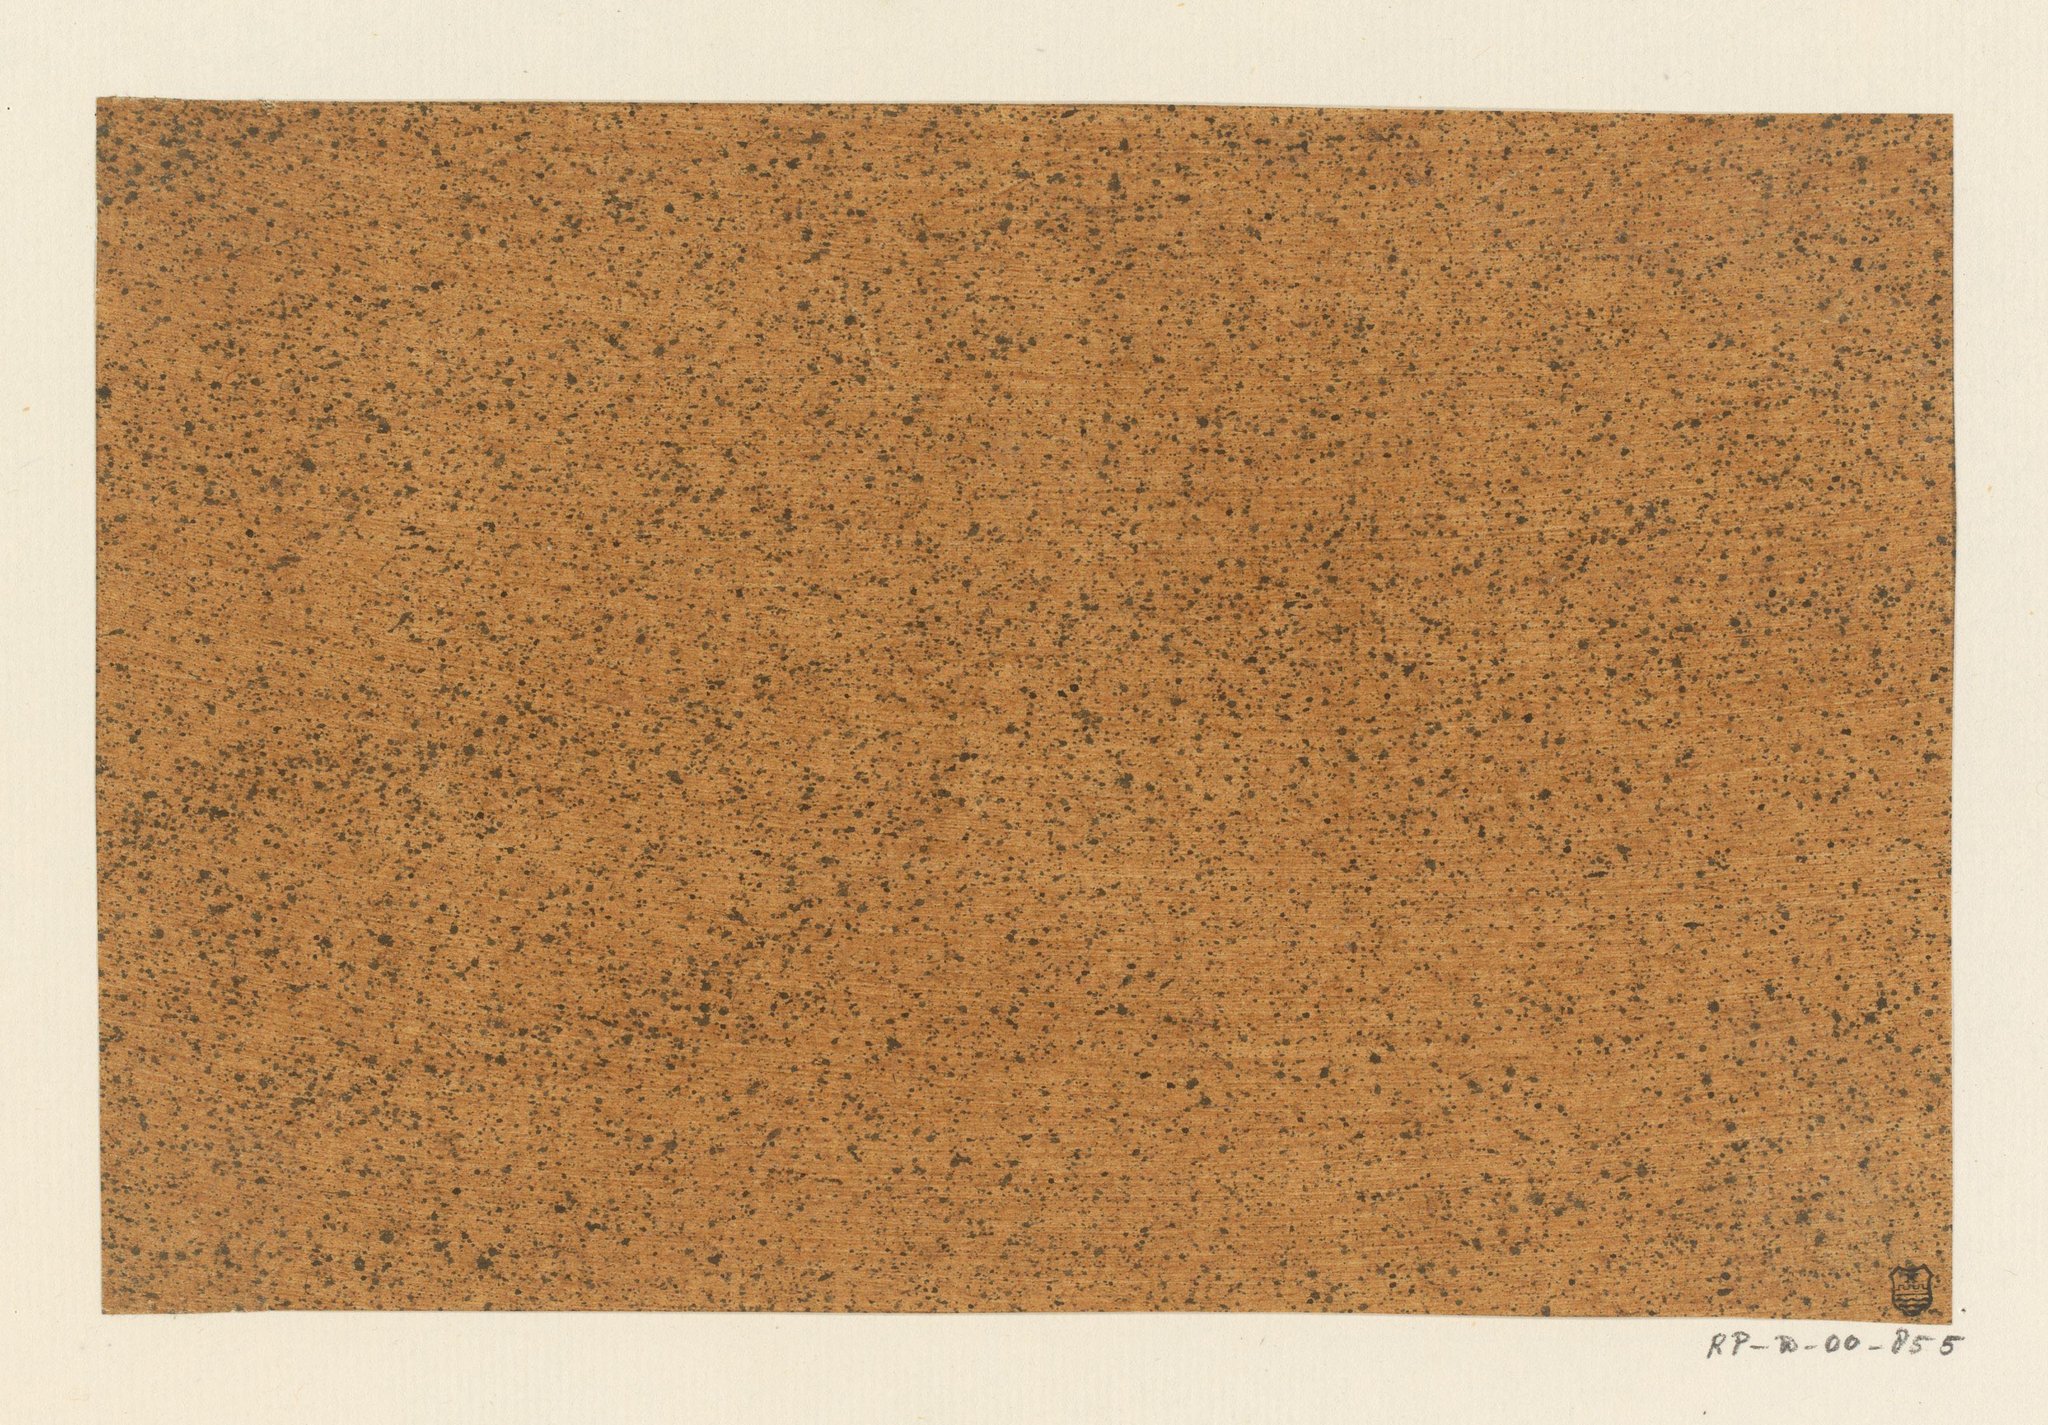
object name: sprinkled paper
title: Zwart gespikkeld geelbruin papier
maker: Anonymous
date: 1750-1900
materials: paint, paper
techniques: kievitsmarmer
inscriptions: collector's mark: Lugt 2760